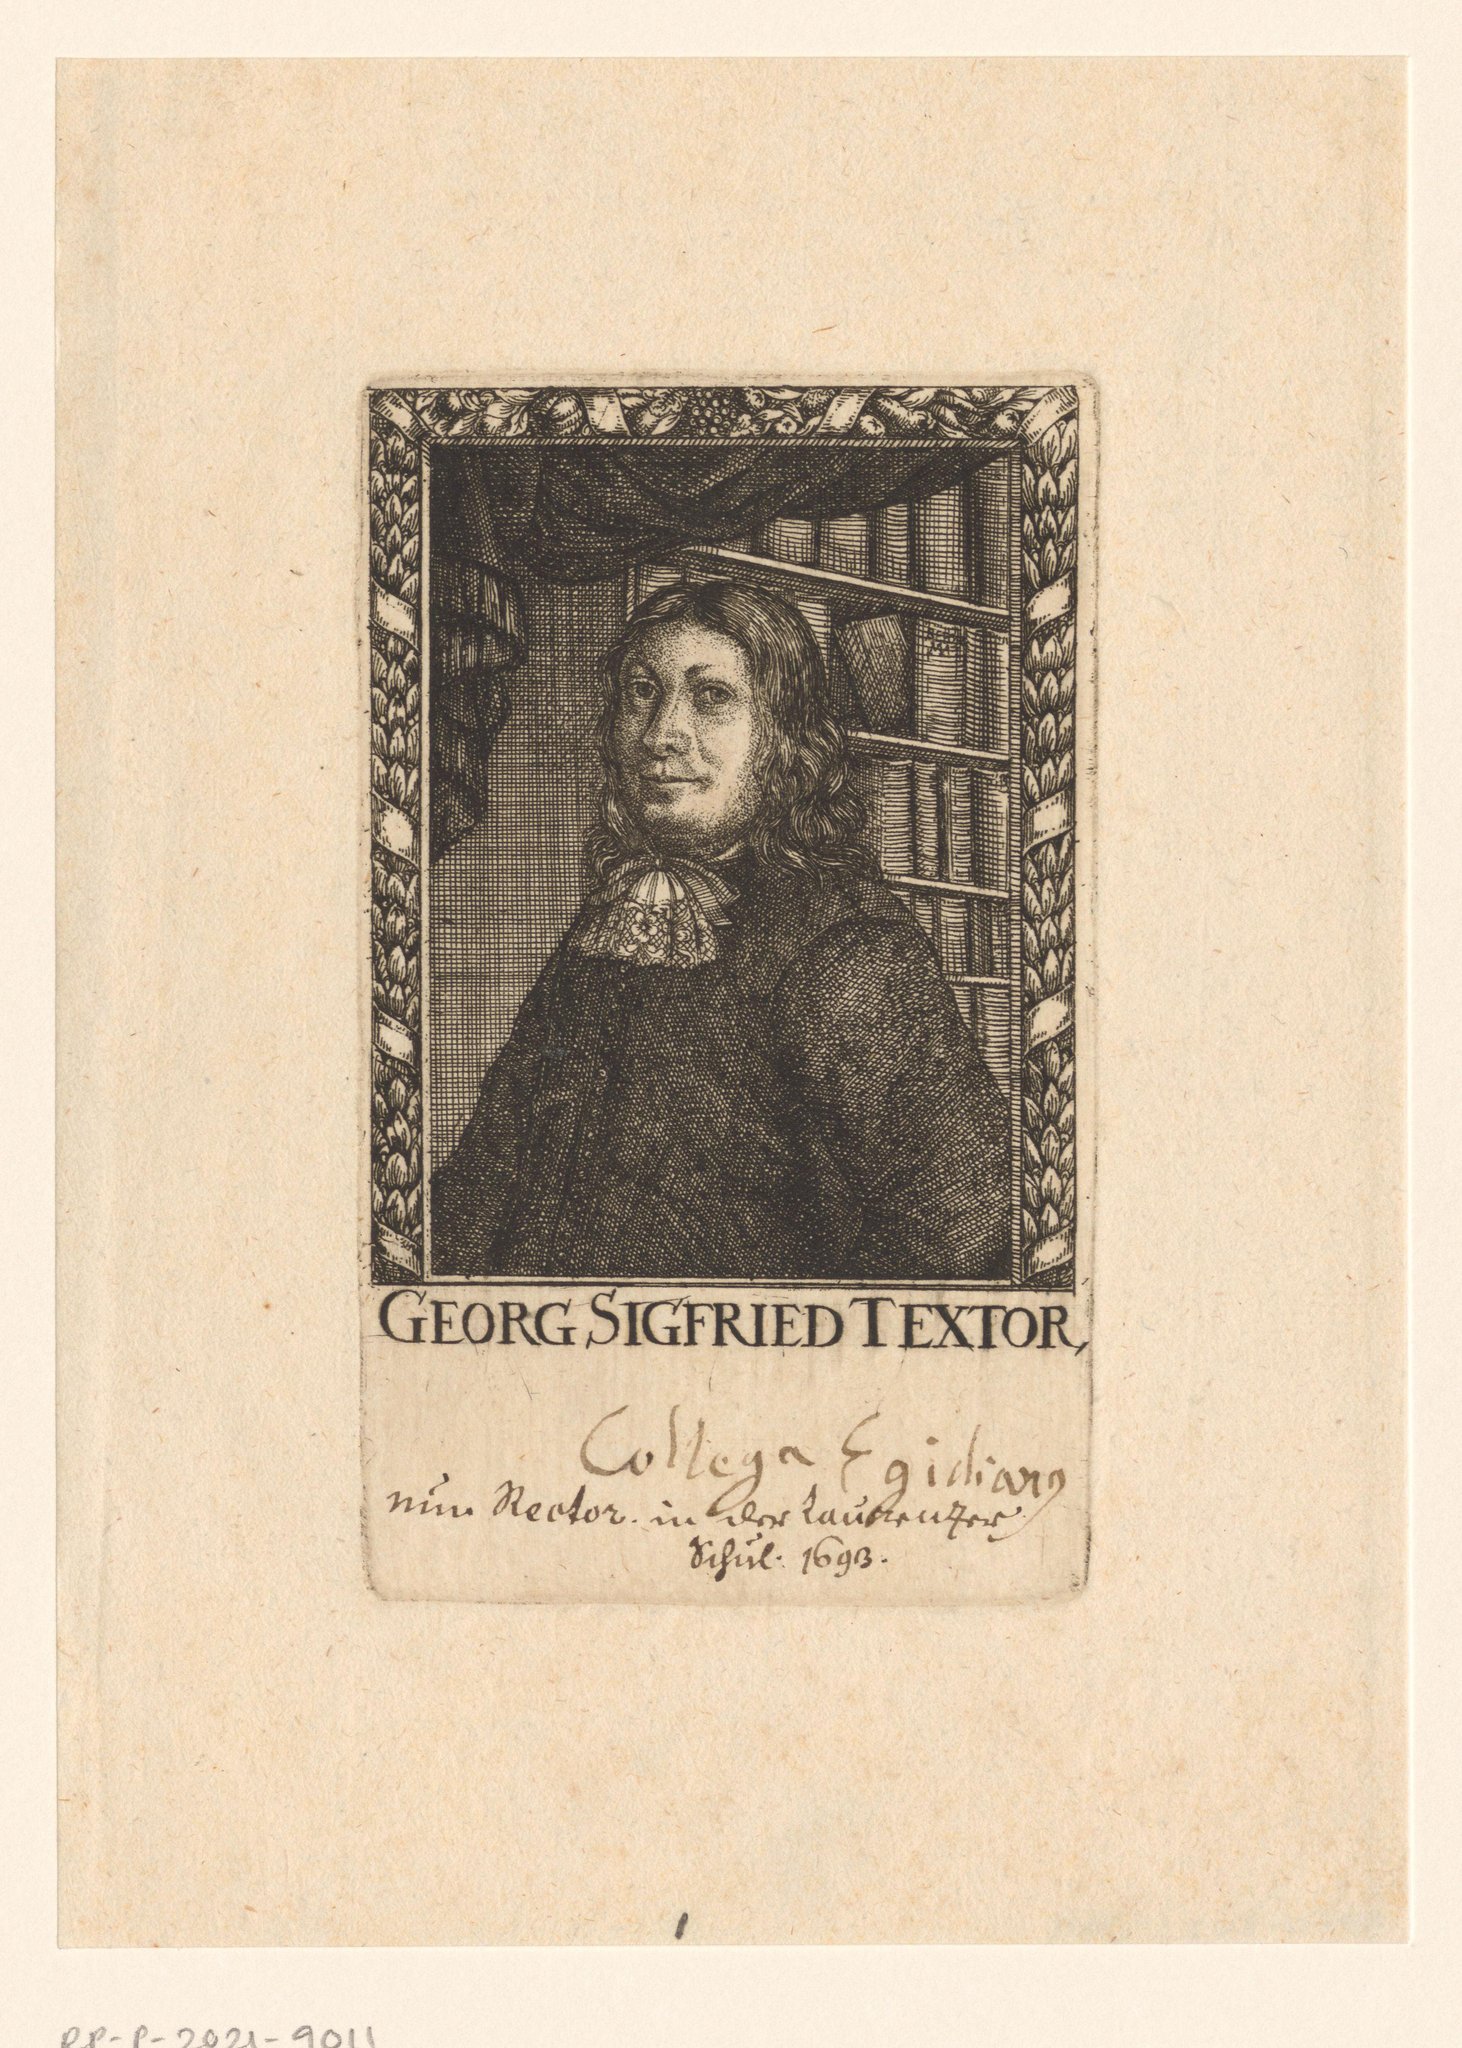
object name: print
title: Portret van Johann Siegfried Textor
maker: johann reinhold mühl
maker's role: print maker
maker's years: 1631-1692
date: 1641-1692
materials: paper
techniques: etching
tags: bookshelves, historical persons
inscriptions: inscription: ‘Collega Egidia[...]/ Rector in [...]/ 1693’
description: Aangeduid als Georg Siegfried Textor, op latere staat aangepast naar Johann Siegfried Textor.